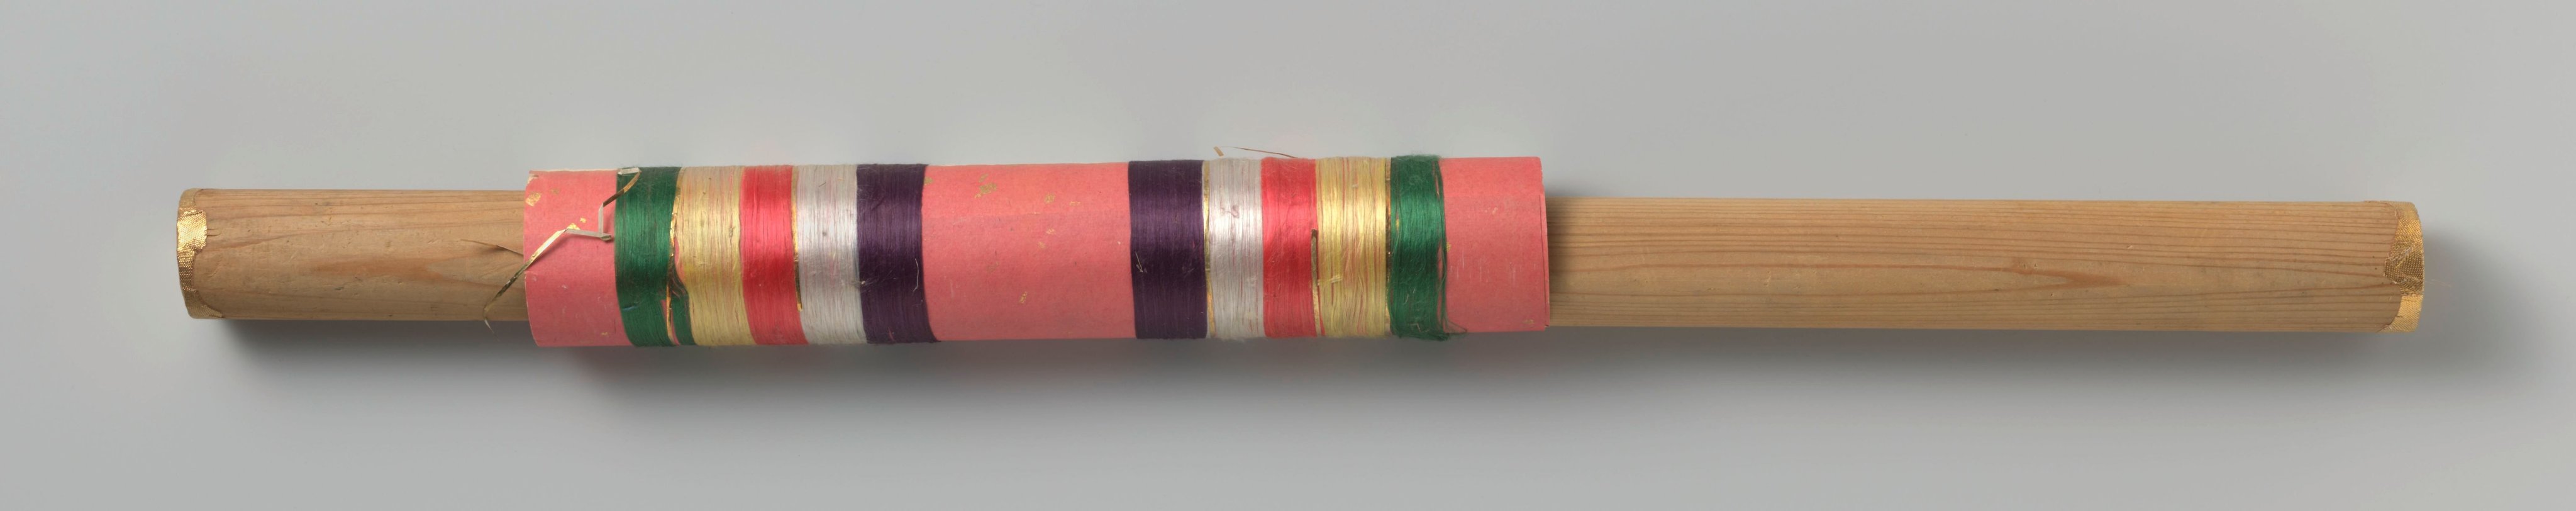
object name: textile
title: Onderdeel van originele verpakking van rollen zijde, bestaande uit een houten stok, beplakt met weefsel, goudpapier enomwonden met strengen ongewonden zijde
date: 1900-1920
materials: paper, silk, wood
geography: japan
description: Houten stok, onderdeel van de originele verpakking van rollen zijde. De stok is aan de uiteinden beplakt met geschulpt weefsel in satijnbinding van gouddraad. Om de stok gevouwen een dubbelgevouwen roze papier met plaatselijk aangebrachte stippen bladgoud, omwonden met strengen ongewonden zijde in groen, geel, roze, wit, paars en stroken goudpapier. Oosterse textiel.